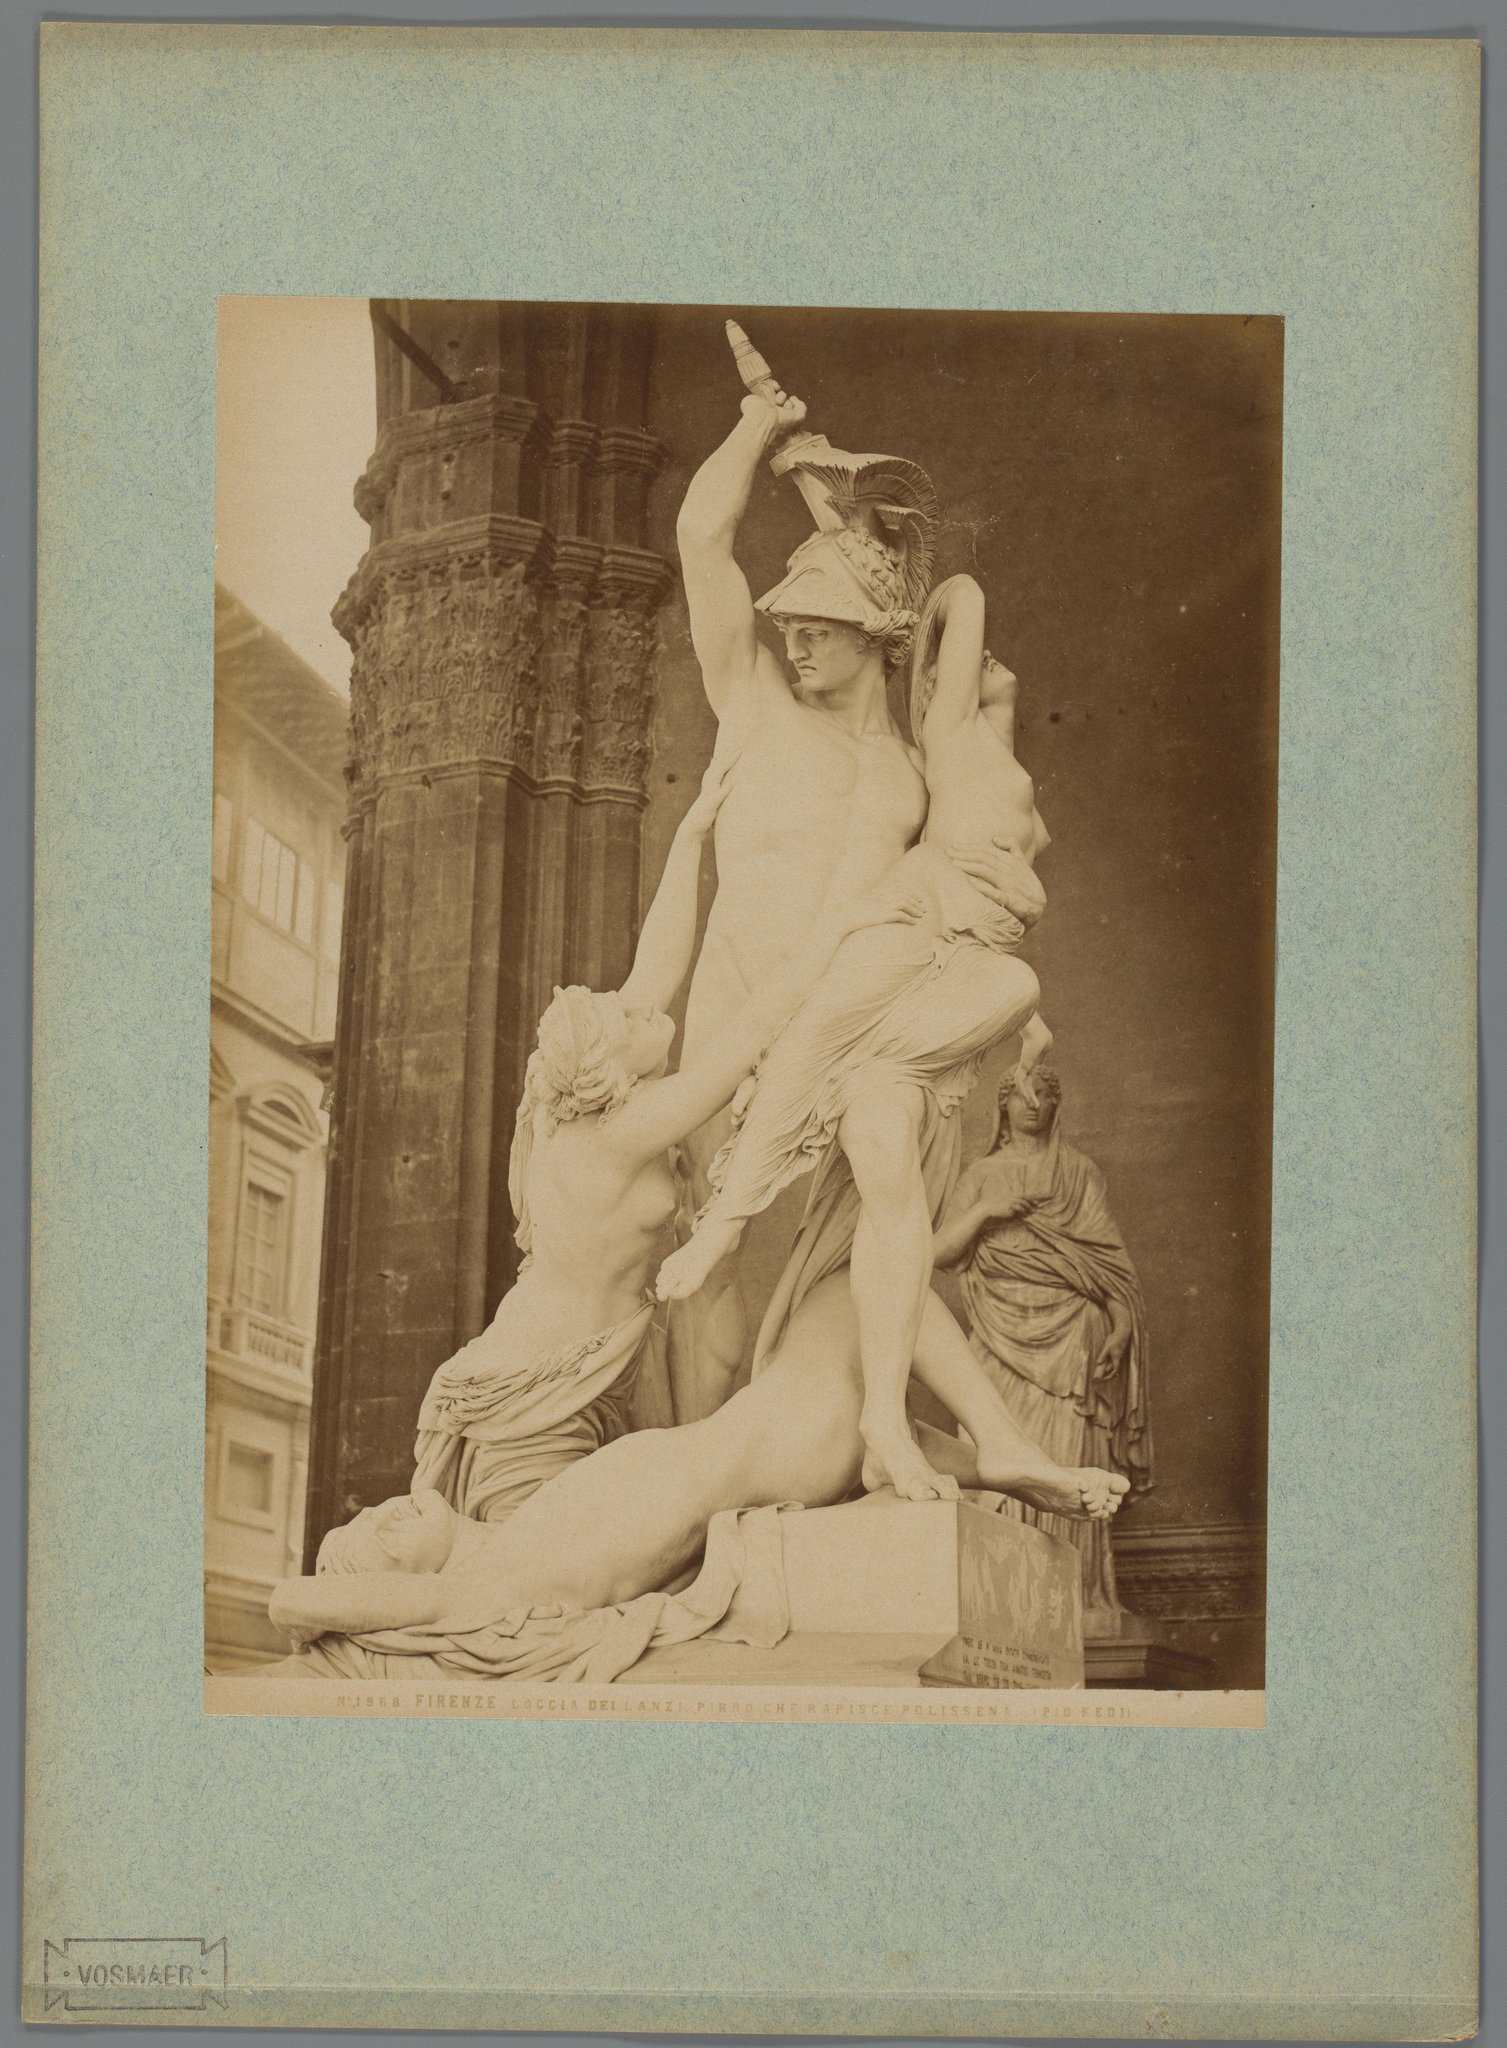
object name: photograph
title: Firenze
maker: pio fedi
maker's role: sculptor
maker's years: 1815-1892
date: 1865-1900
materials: cardboard, paper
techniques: albumen print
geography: florence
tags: piece of sculpture, reproduction of a piece of sculpture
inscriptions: number: ‘No. 1568’, collector's mark: ‘VOSMAER’